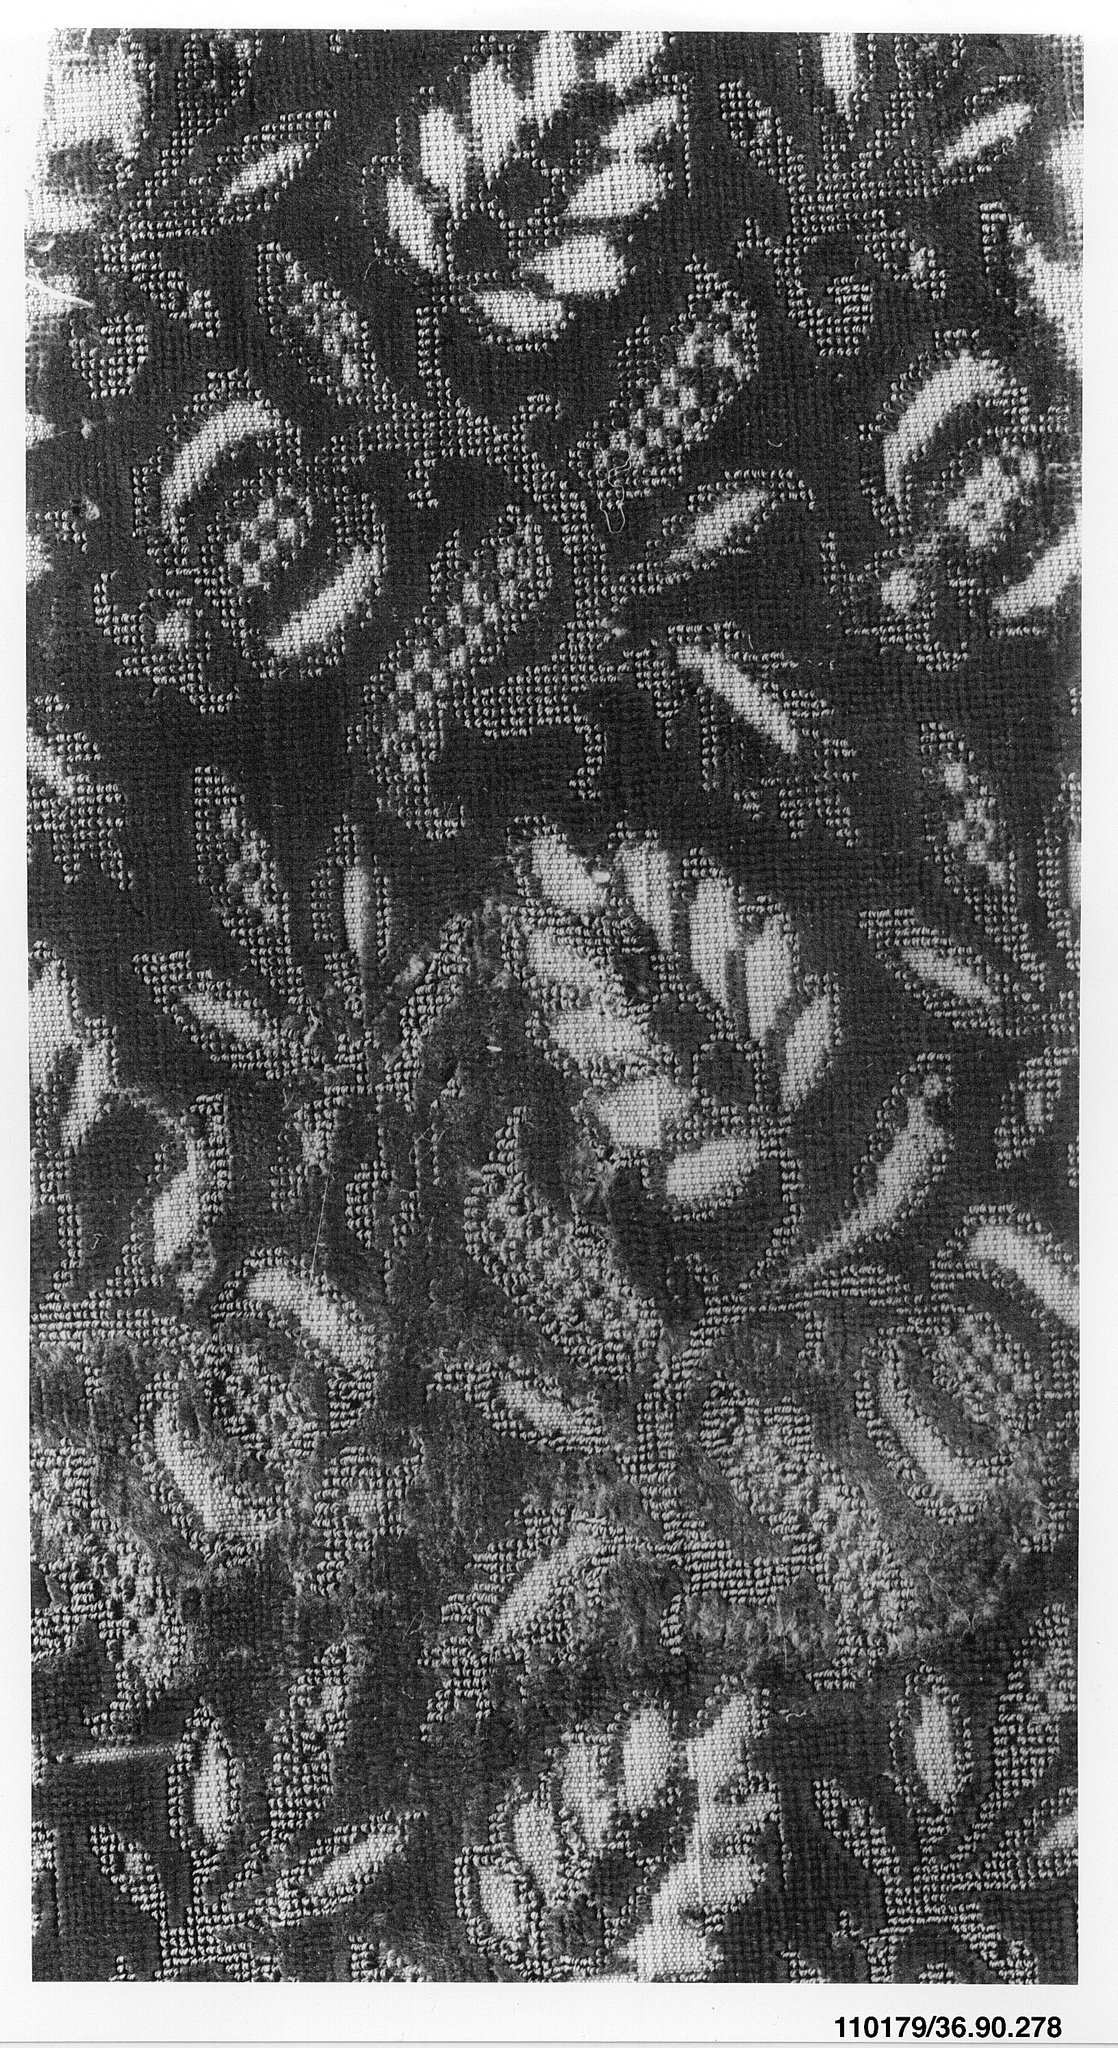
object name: piece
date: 1501-1700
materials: silk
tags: leaves